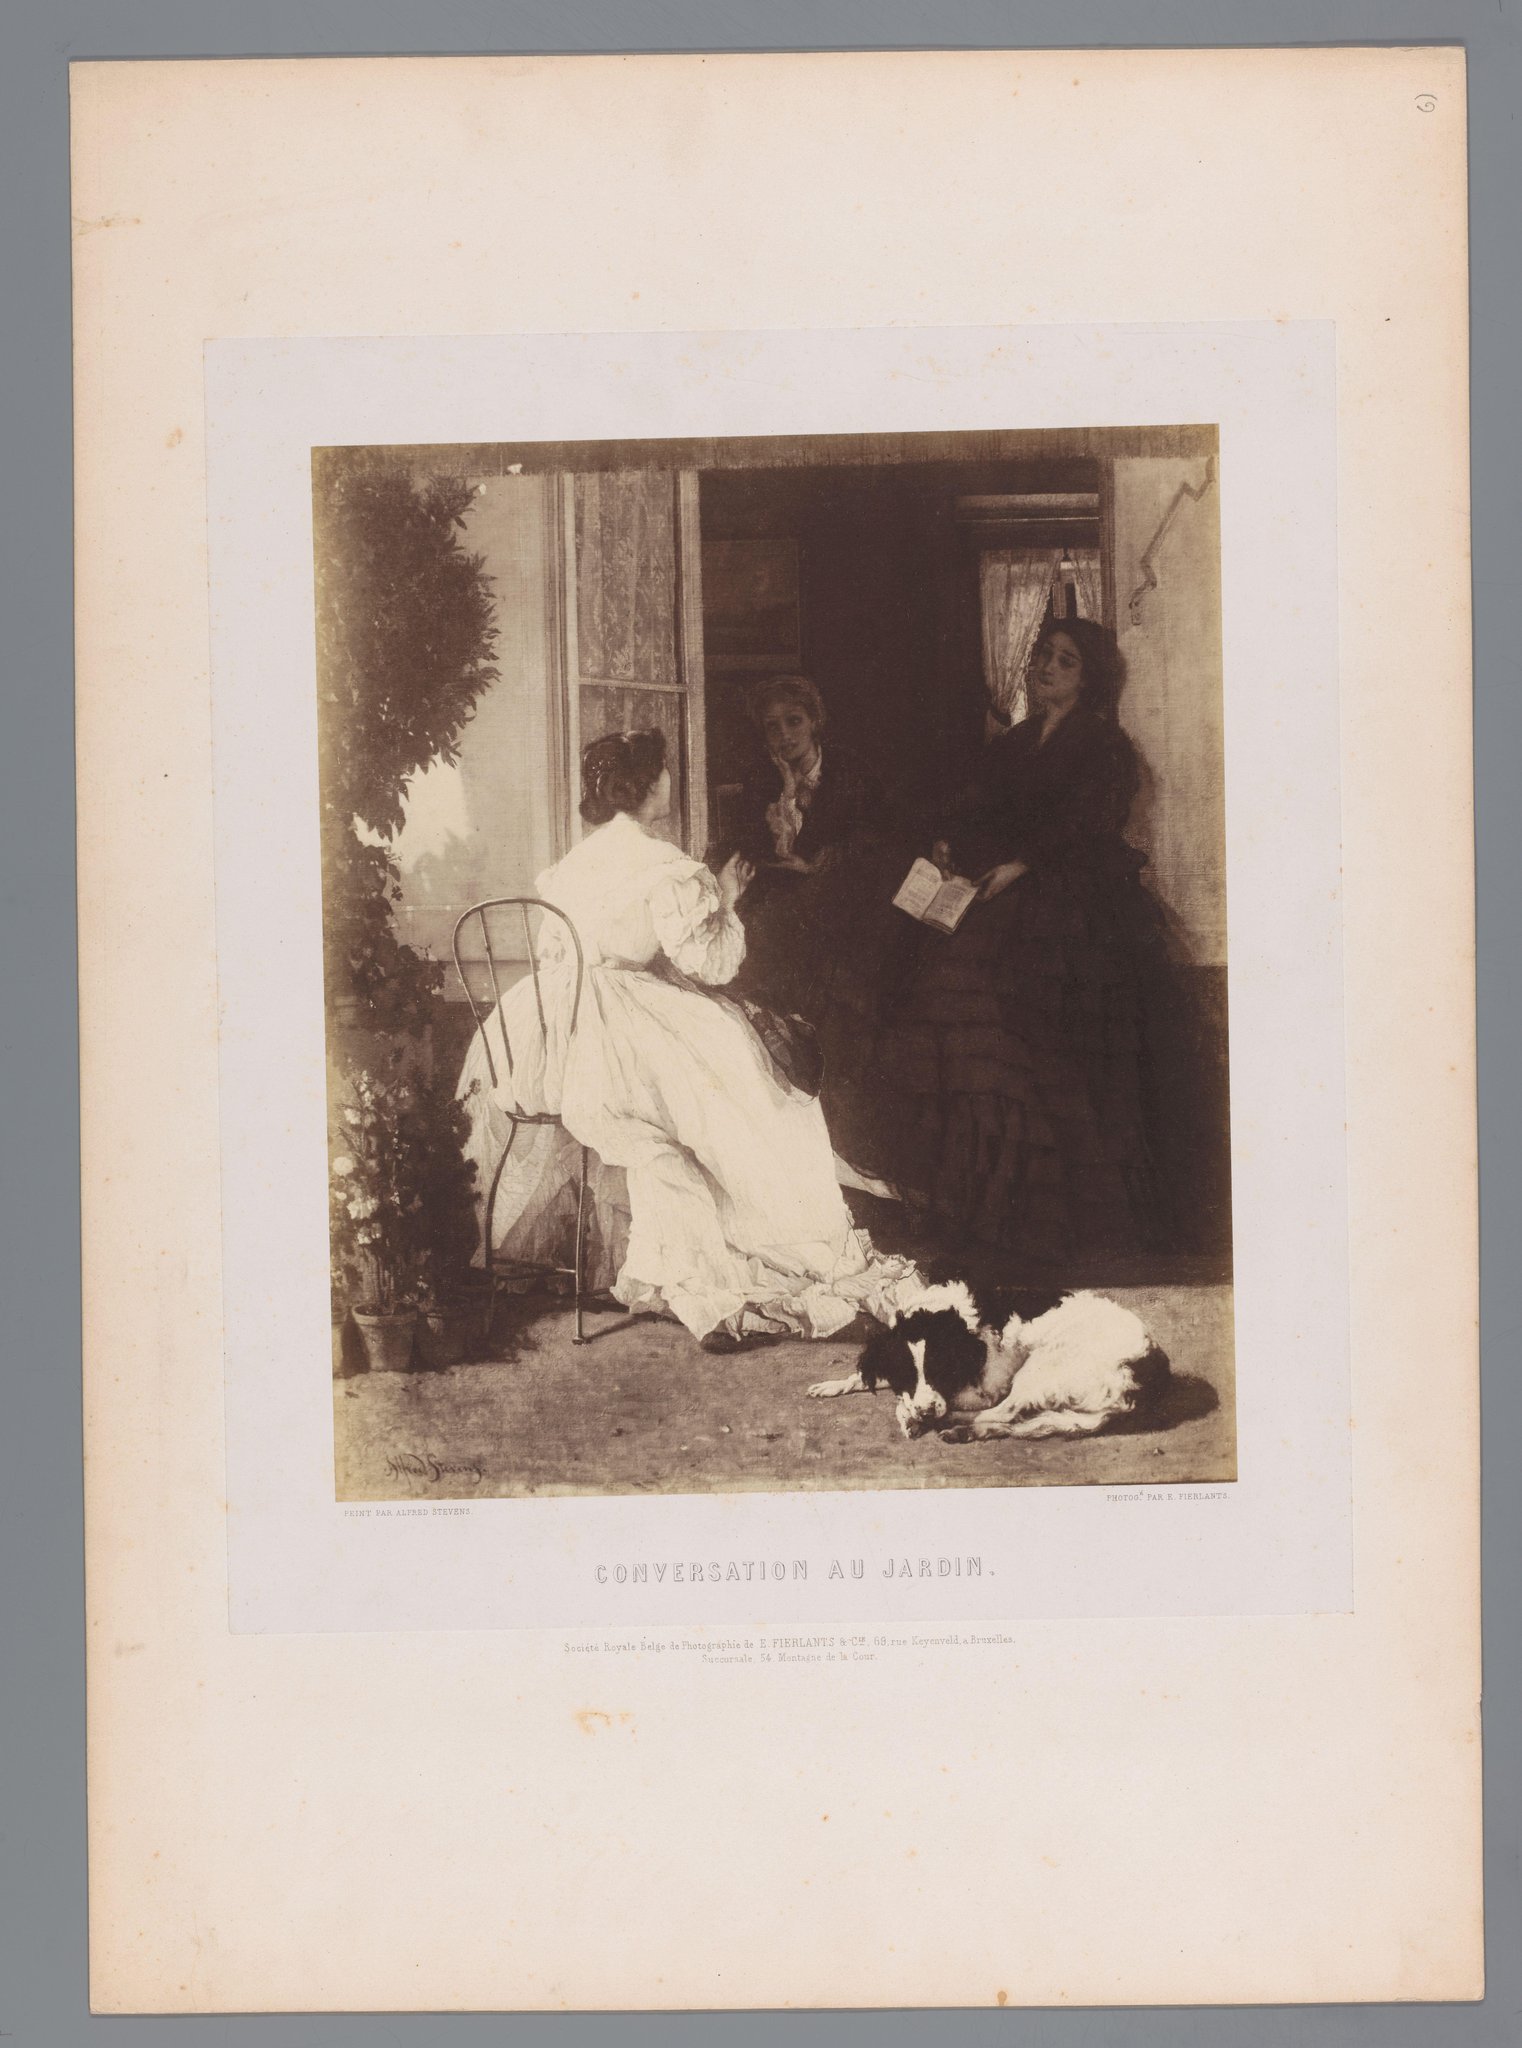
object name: reproduction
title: Fotoreproductie van een schilderij van drie vrouwen tijdens een gesprek in een tuin door Alfred Stevens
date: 1858-1863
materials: photographic support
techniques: albumen print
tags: garden, adult woman (+ three persons), conversation, dialogue; conversation piece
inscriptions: number: ‘6)’, inscription: ‘Société Royal Belge de Photographie. E. Fierlants et Cie., 69, rue Keyenveld, à Bruxelles./ Succursale, 54, Montagne de la Cour, à Bruxelles.’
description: Deze foto maakt deel uit van een omslag met zeven foto's, twee titelbladen en een lijst van afbeeldingen.